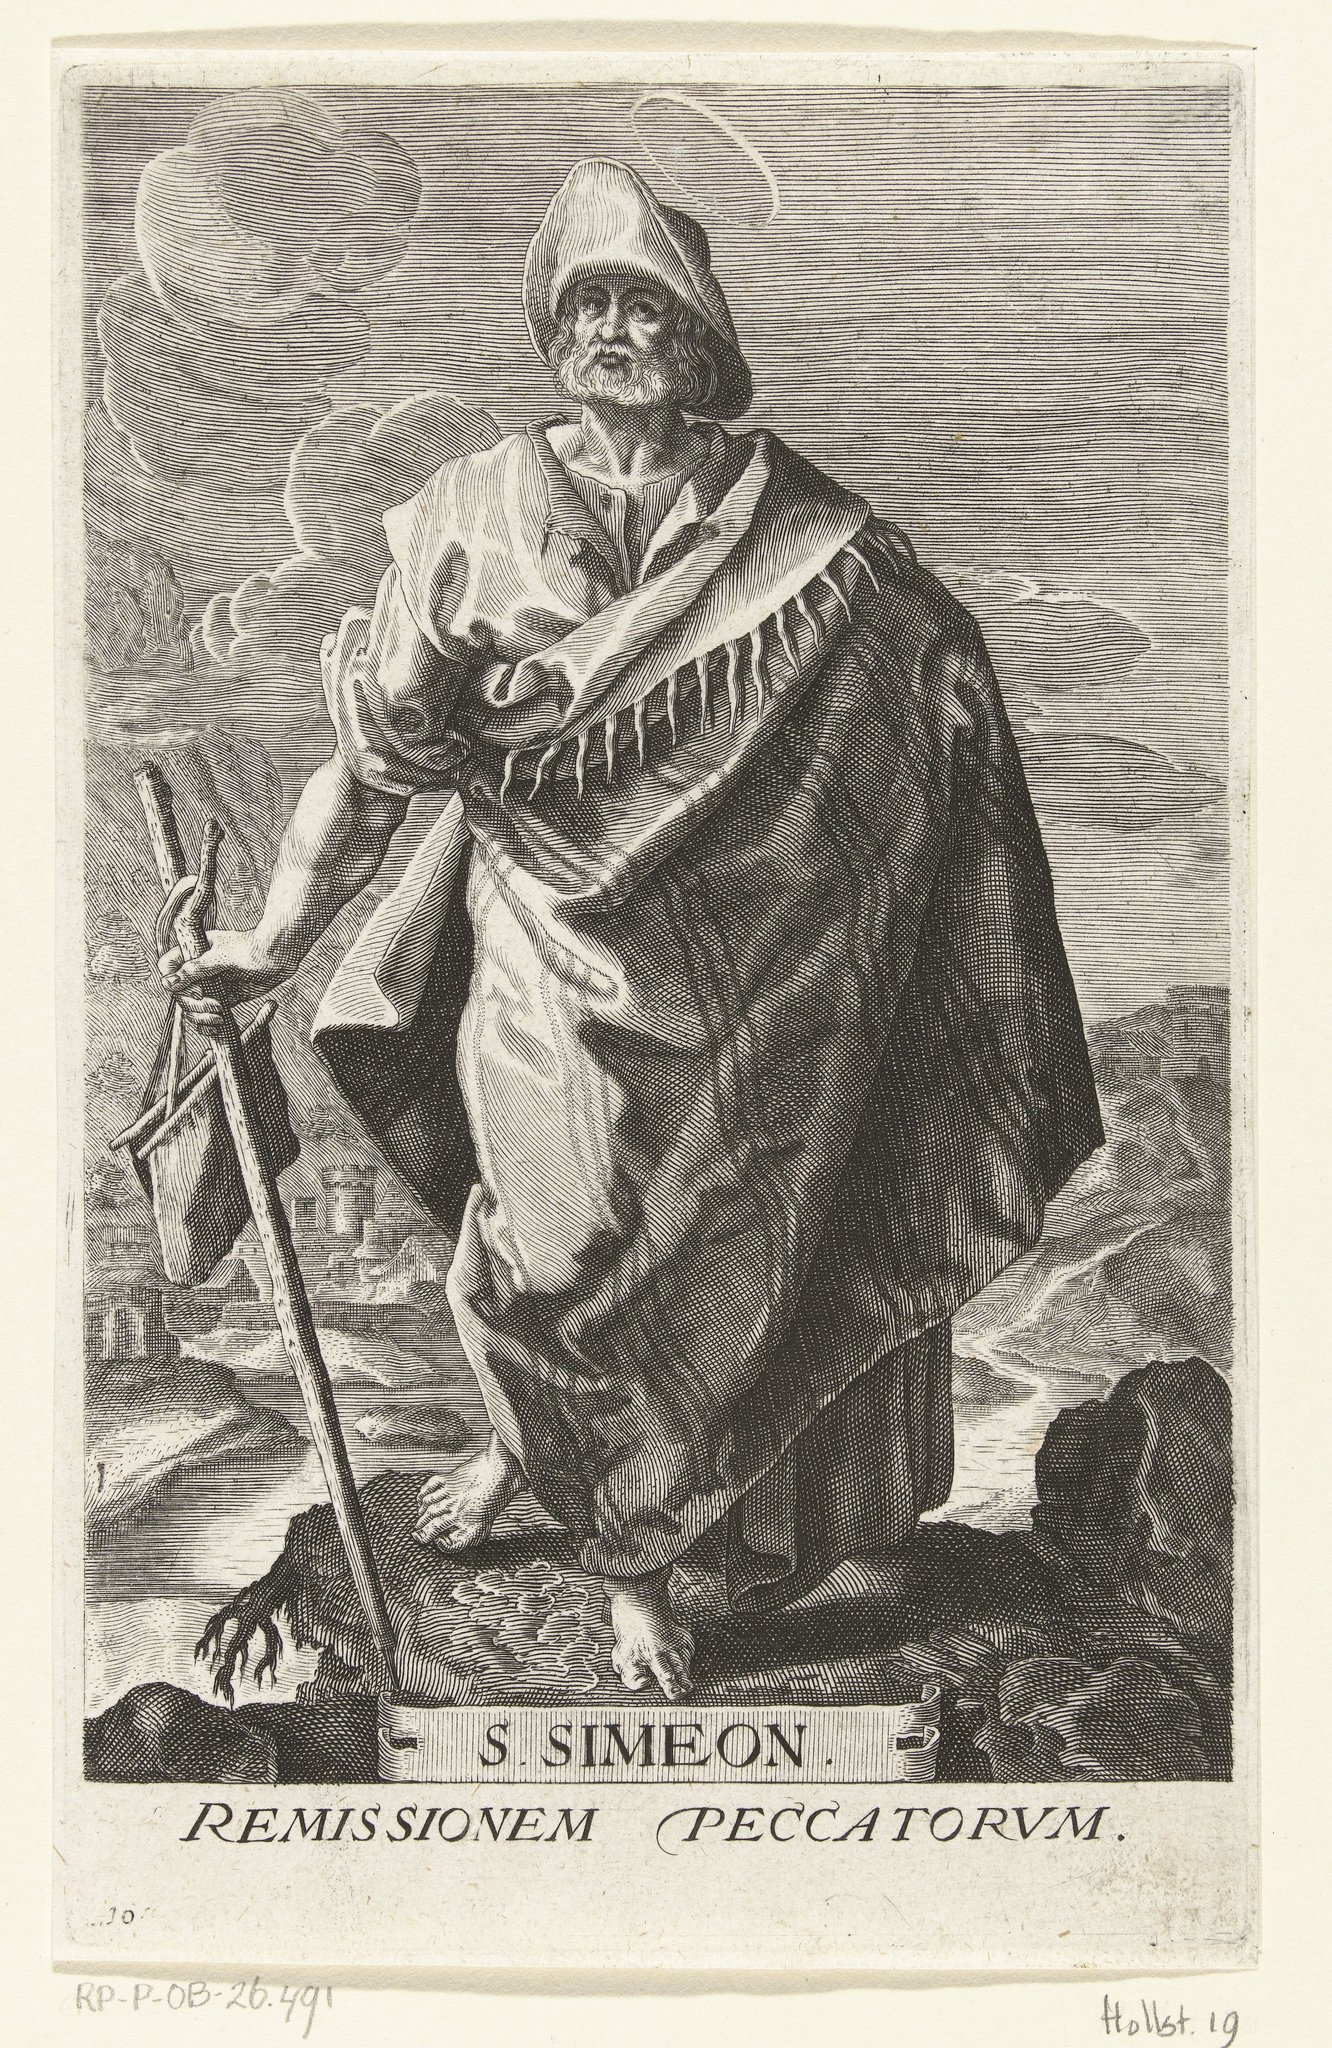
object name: print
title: S. Simeon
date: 1591-1629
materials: paper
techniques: engraving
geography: prague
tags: the apostle simon zelotes (or simon the canaanite); possible attributes: book, saw, scroll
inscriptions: collector's mark: Lugt 2228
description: Prent naar ontwerp van Joos van Winghe. Prent maakt deel uit van serie met dertien prenten en titelprent van Christus en twaalf apostelen.